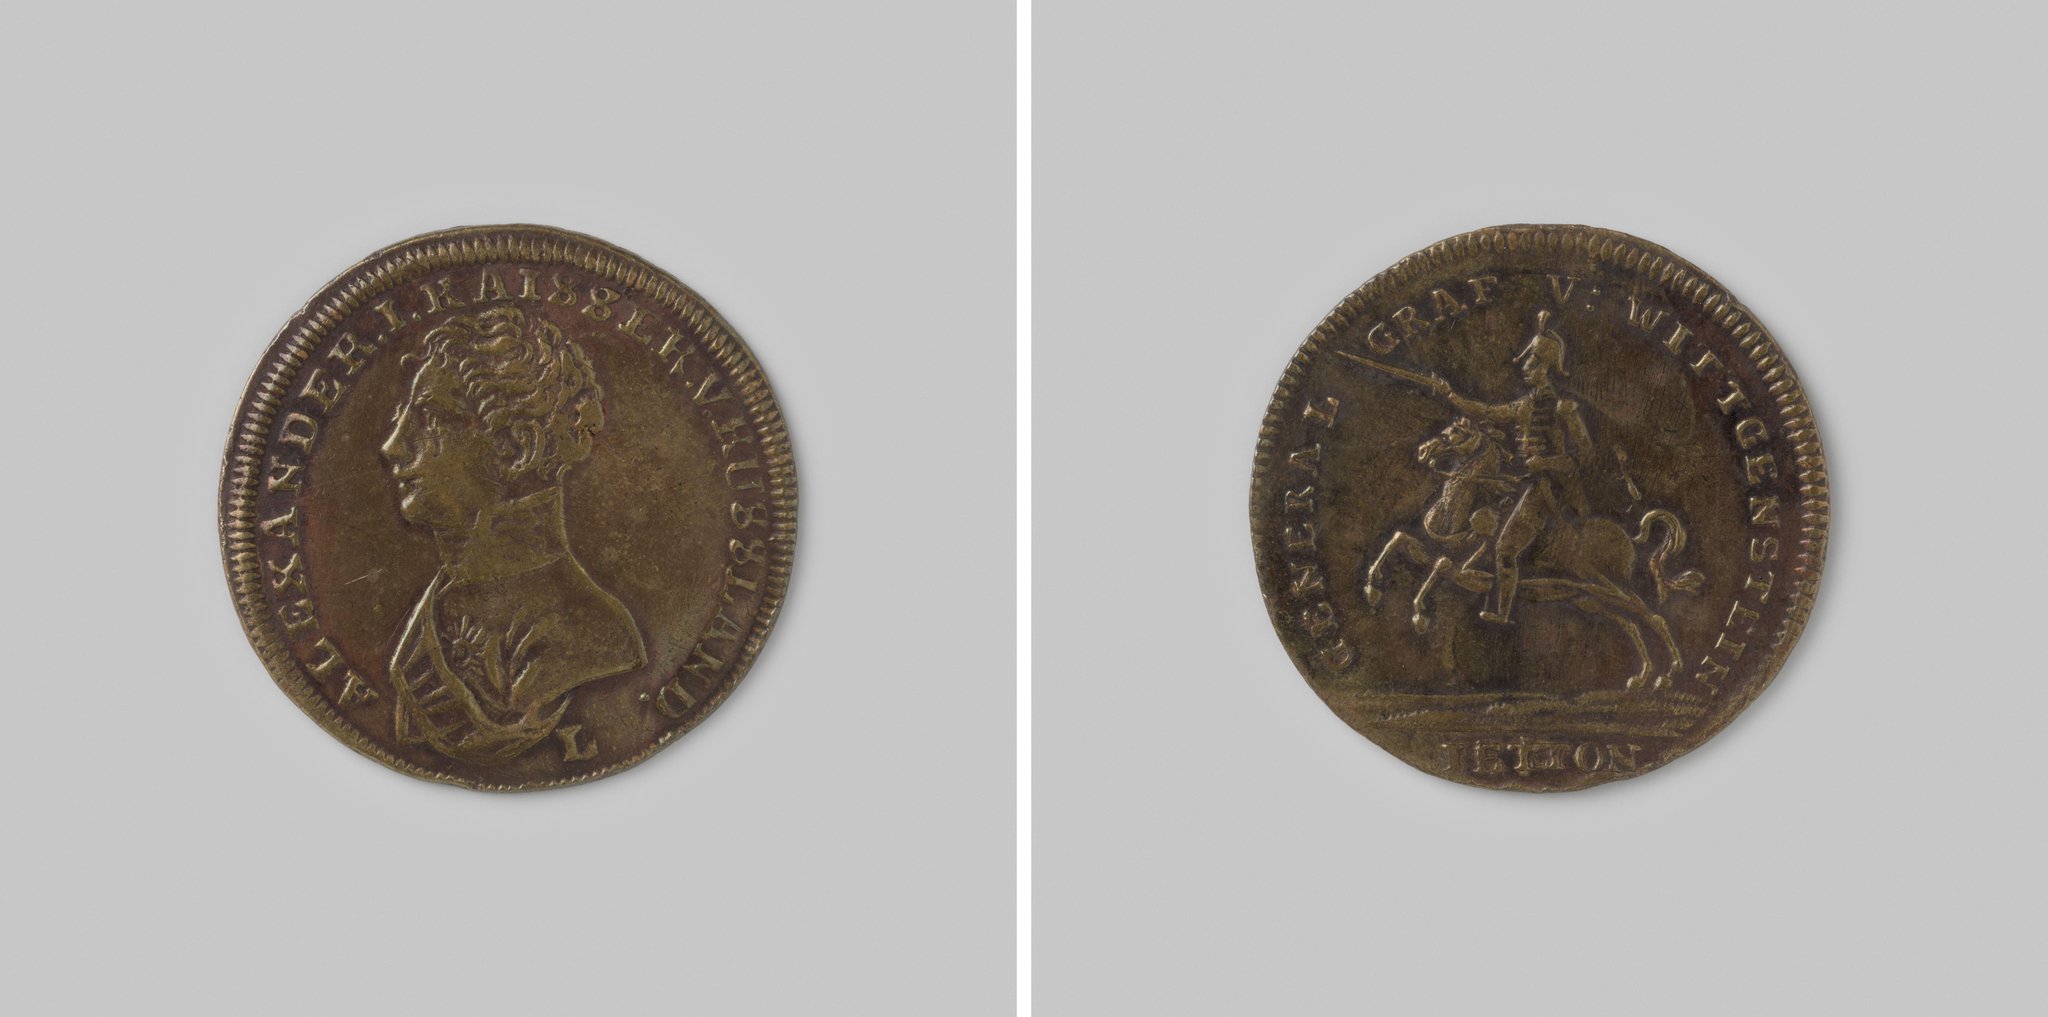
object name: history medal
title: Speelpenning uit Neurenberg met Tsaar Alexander I en Generaal von Wittgenstein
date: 1813-1820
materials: brass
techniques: striking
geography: nuremberg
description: Messing penning, op de voorzijde het botrstbeeld van Tsaar Alexander naar links met omschrift, op de keerzijde Von Wittgenstein te paard naar links, de sabel vooruitwijzend, met omschrift en afsnedetekst.